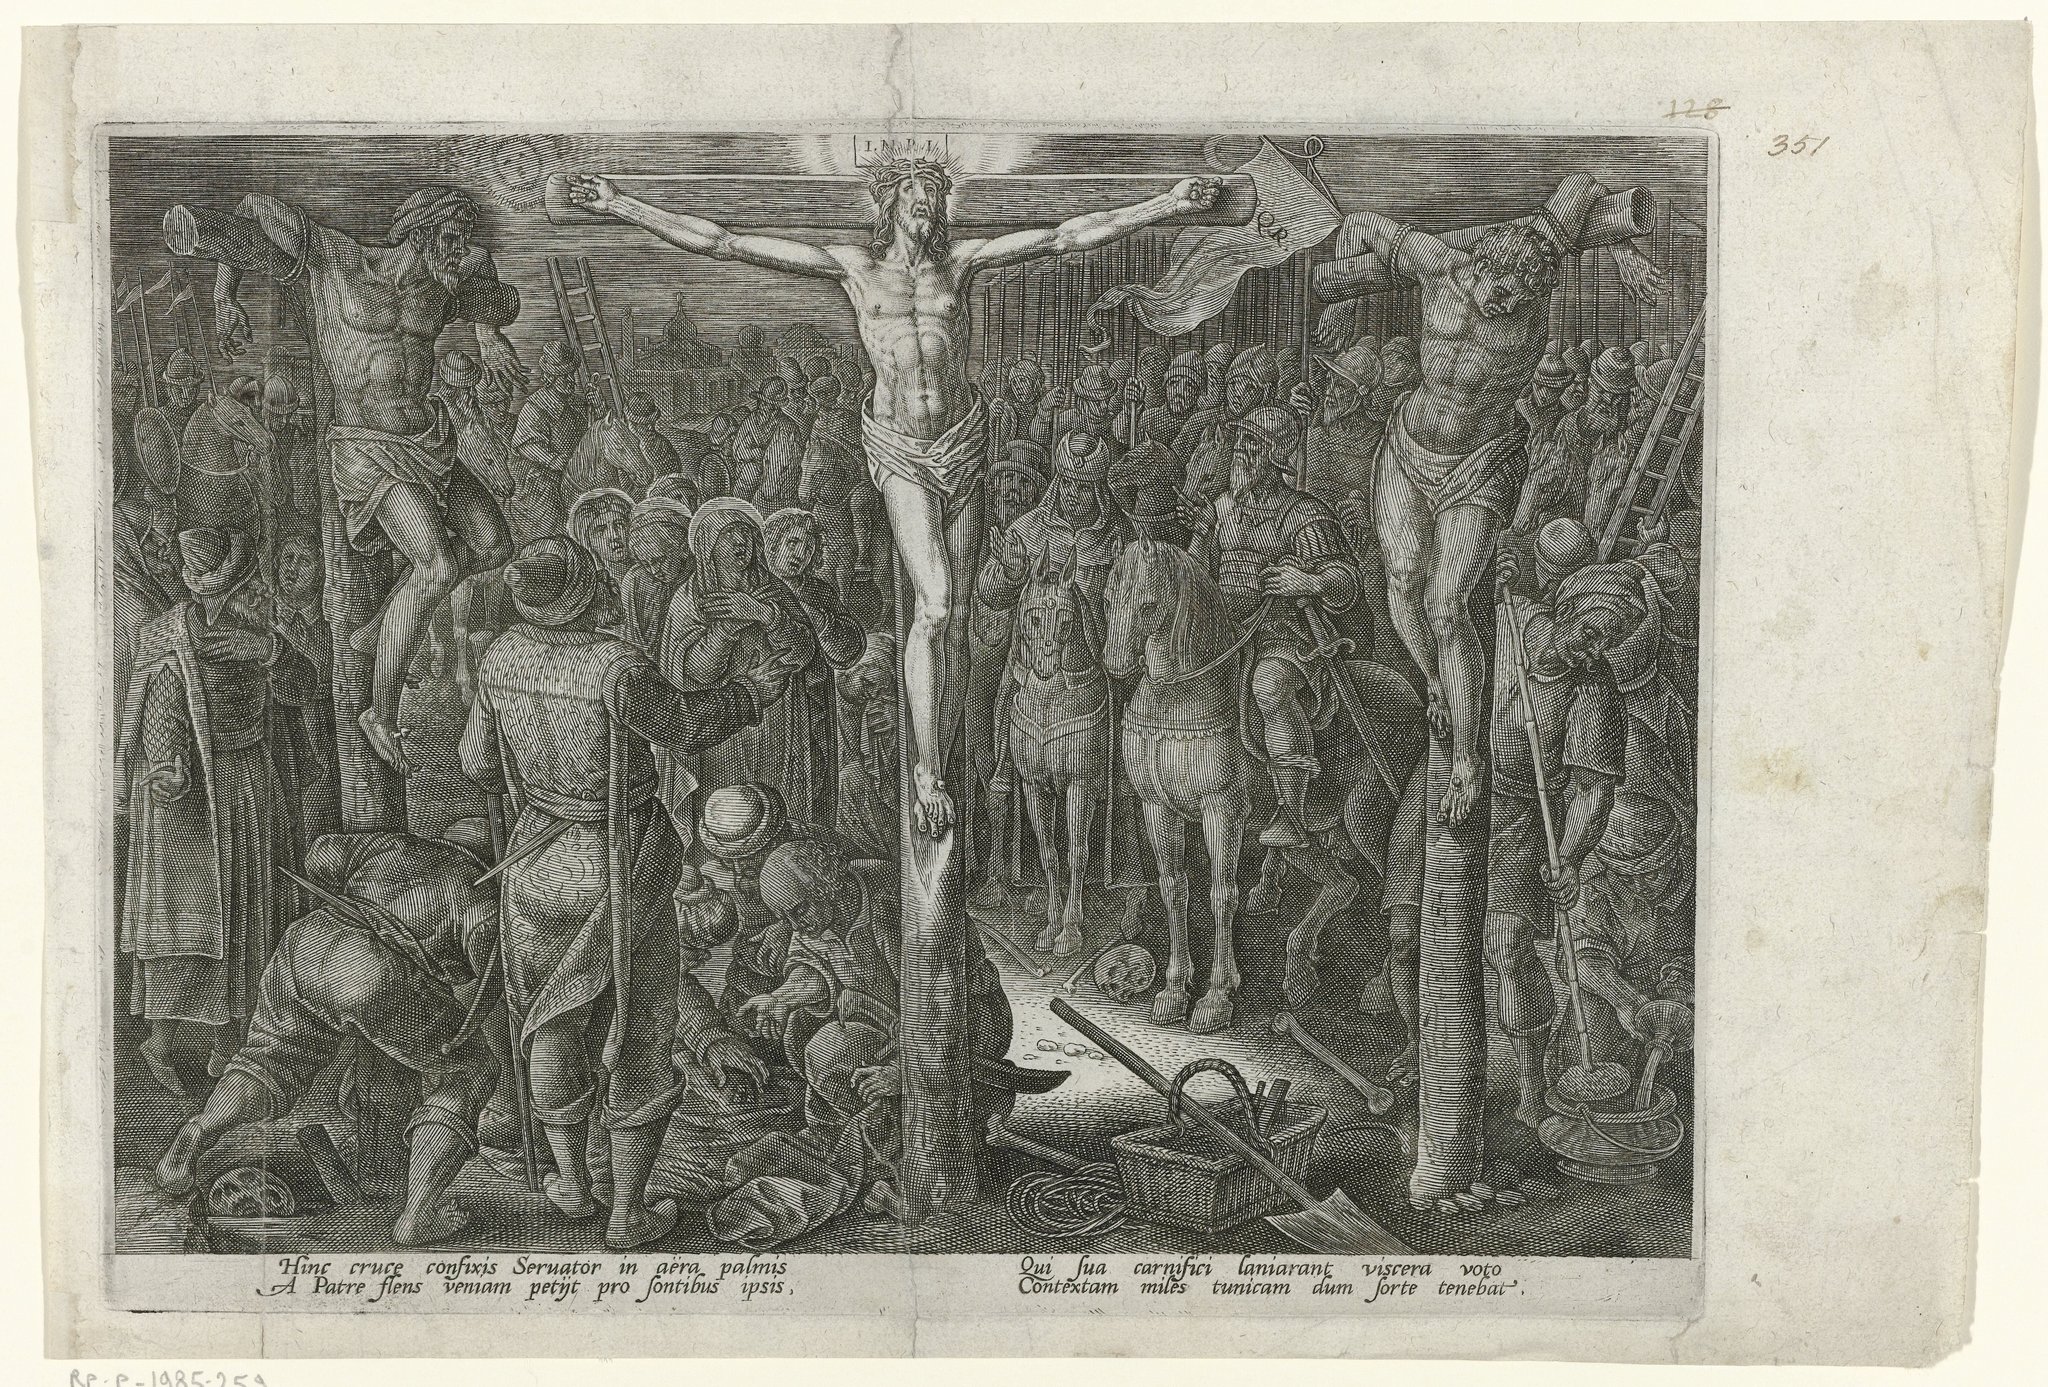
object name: print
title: Christus aan het kruis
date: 1585-1586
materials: paper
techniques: engraving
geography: antwerp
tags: soldiers throwing dice for christ's seamless garment ~ christ's death on the cross, bystanders at the foot of the cross, among whom mary, mary magdalene and john the evangelist; mary may be shown swooning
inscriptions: collector's mark: 2760, number: ‘351’, collector's mark: Lugt 2228, watermark:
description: Christus aan het kruis, tussen de twee misdadigers (Johannes 19:18). Onder het kruis dobbelen drie soldaten om de mantel van Christus. Maria wordt getroost door Johannes en Maria Magdalena. De prent heeft een Latijns onderschrift en maakt deel uit van een serie over de passie, dood en wederopstanding van Christus.